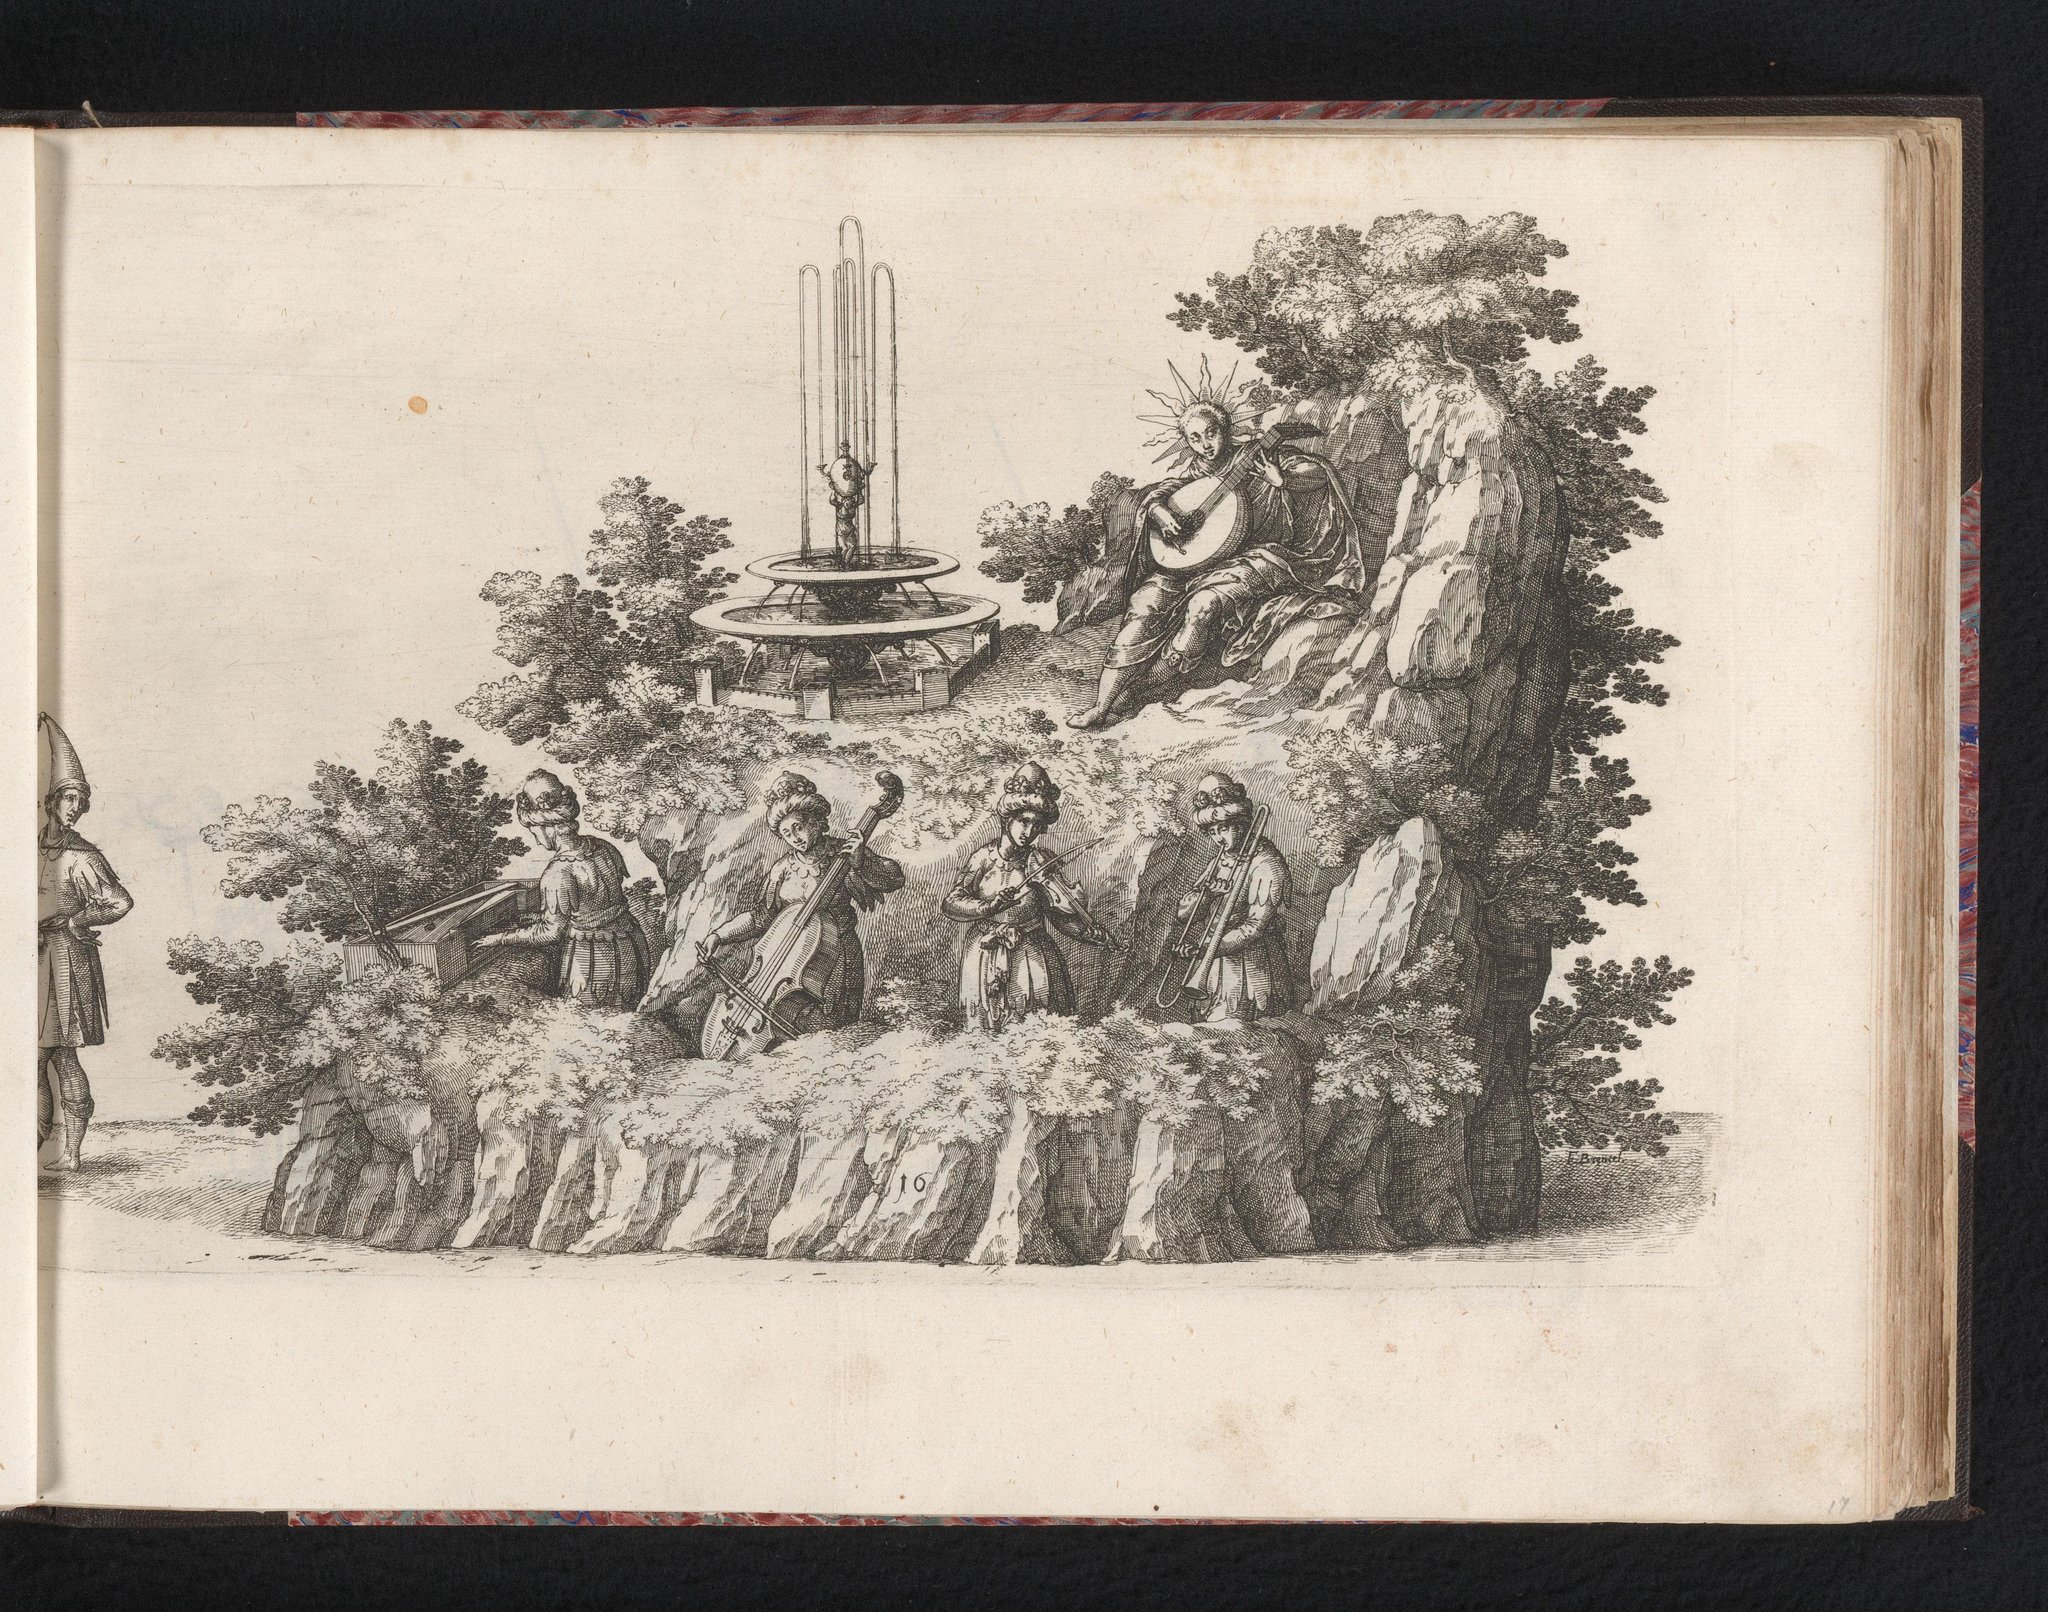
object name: album leaf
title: Optochten en ruiterspelen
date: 1618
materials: paper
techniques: etching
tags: riding a horse, ass, or mule; rider, horseman, the story of the three wise men (kings or magi) (matthew 2:1-12), performance in the open air (pleasure fair), specific aspects, allegorical aspects of mercury; mercury as patron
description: Mogelijk verbeelden de drie personen de Wijzen uit het Oosten uit het Nieuwe Testament, die hier de doop van de baby Ulrich von Württemberg bezoeken. Deze prent is onderdeel van een serie.